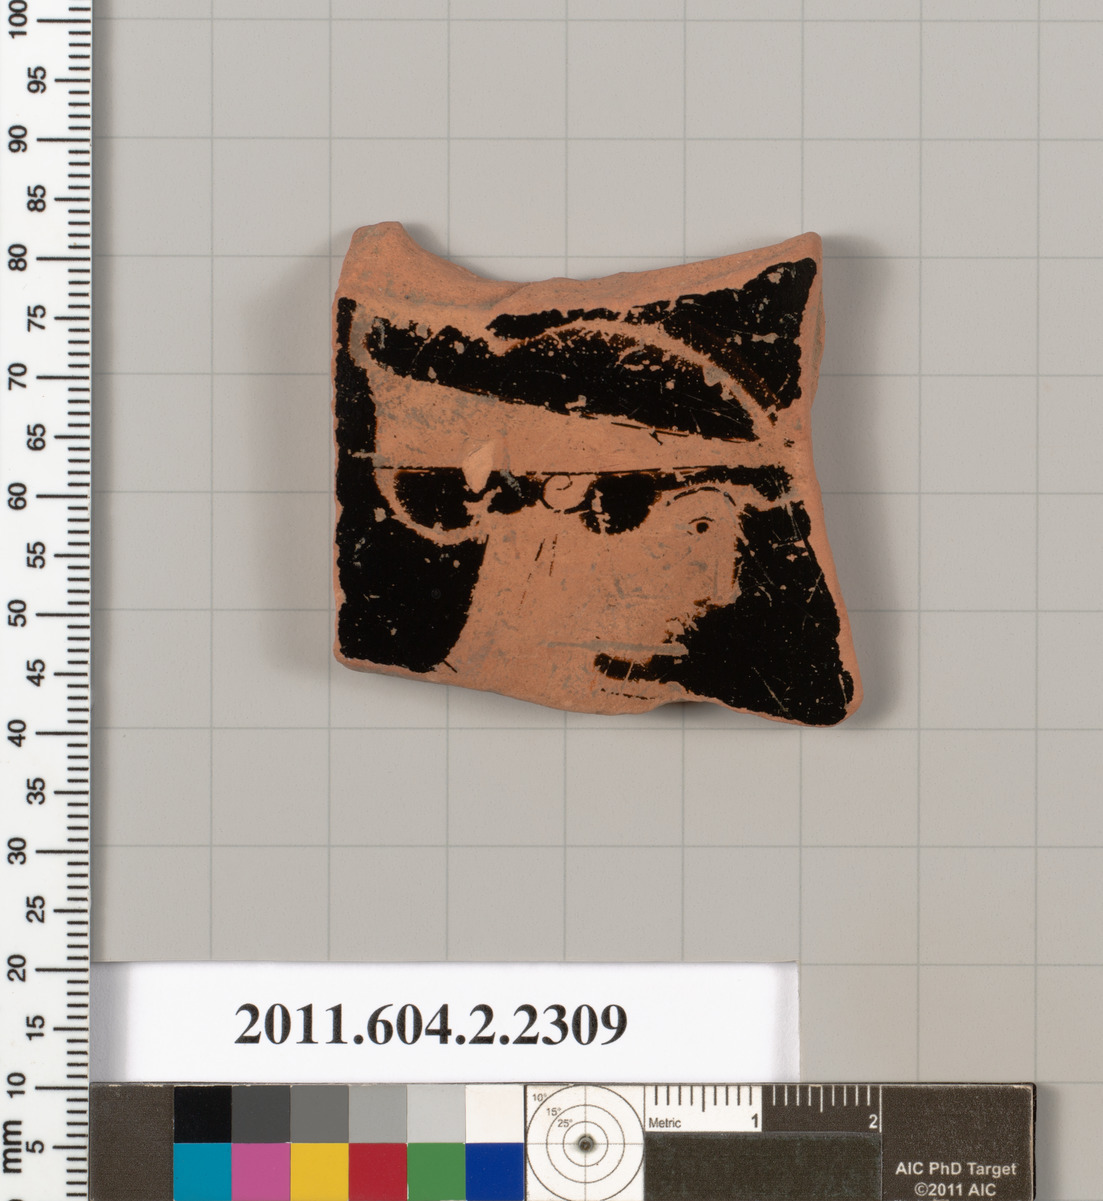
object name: pot fragment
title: Terracotta fragment of a pot; unglazed on the inside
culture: greek, attic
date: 475-451 BCE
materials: terracotta